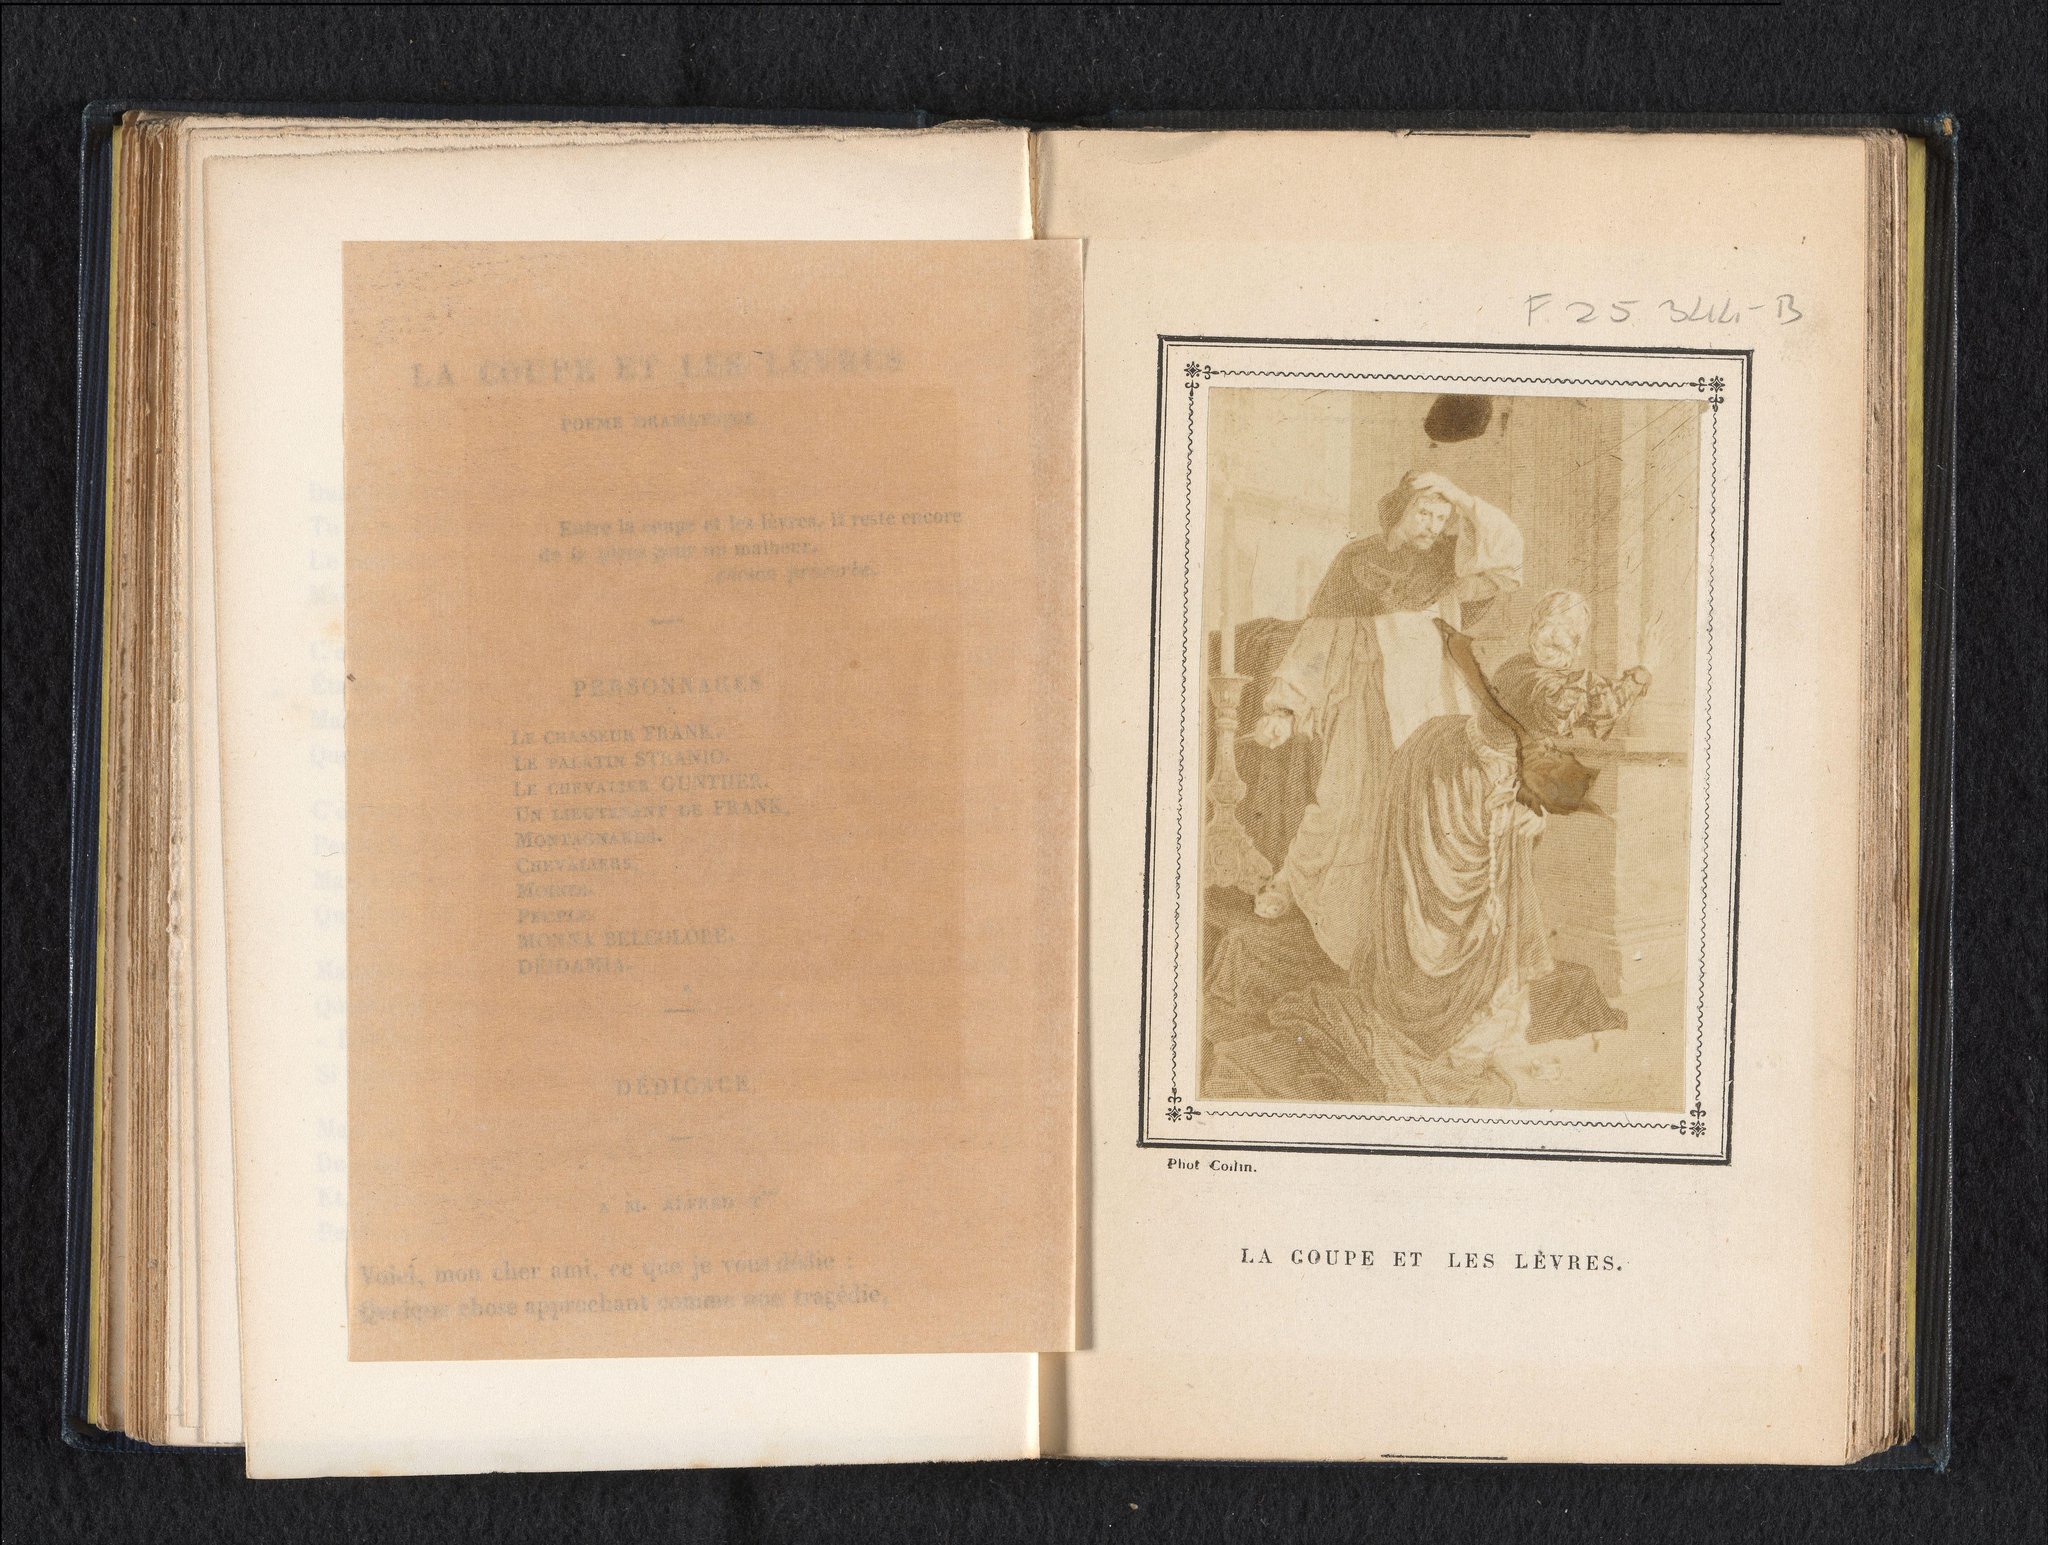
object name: photograph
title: Fotoreproductie van de gravure La coupe et les lèvres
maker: collin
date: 1852-1867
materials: paper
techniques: albumen print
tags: print, e.g.: engraving, etching, lithograph